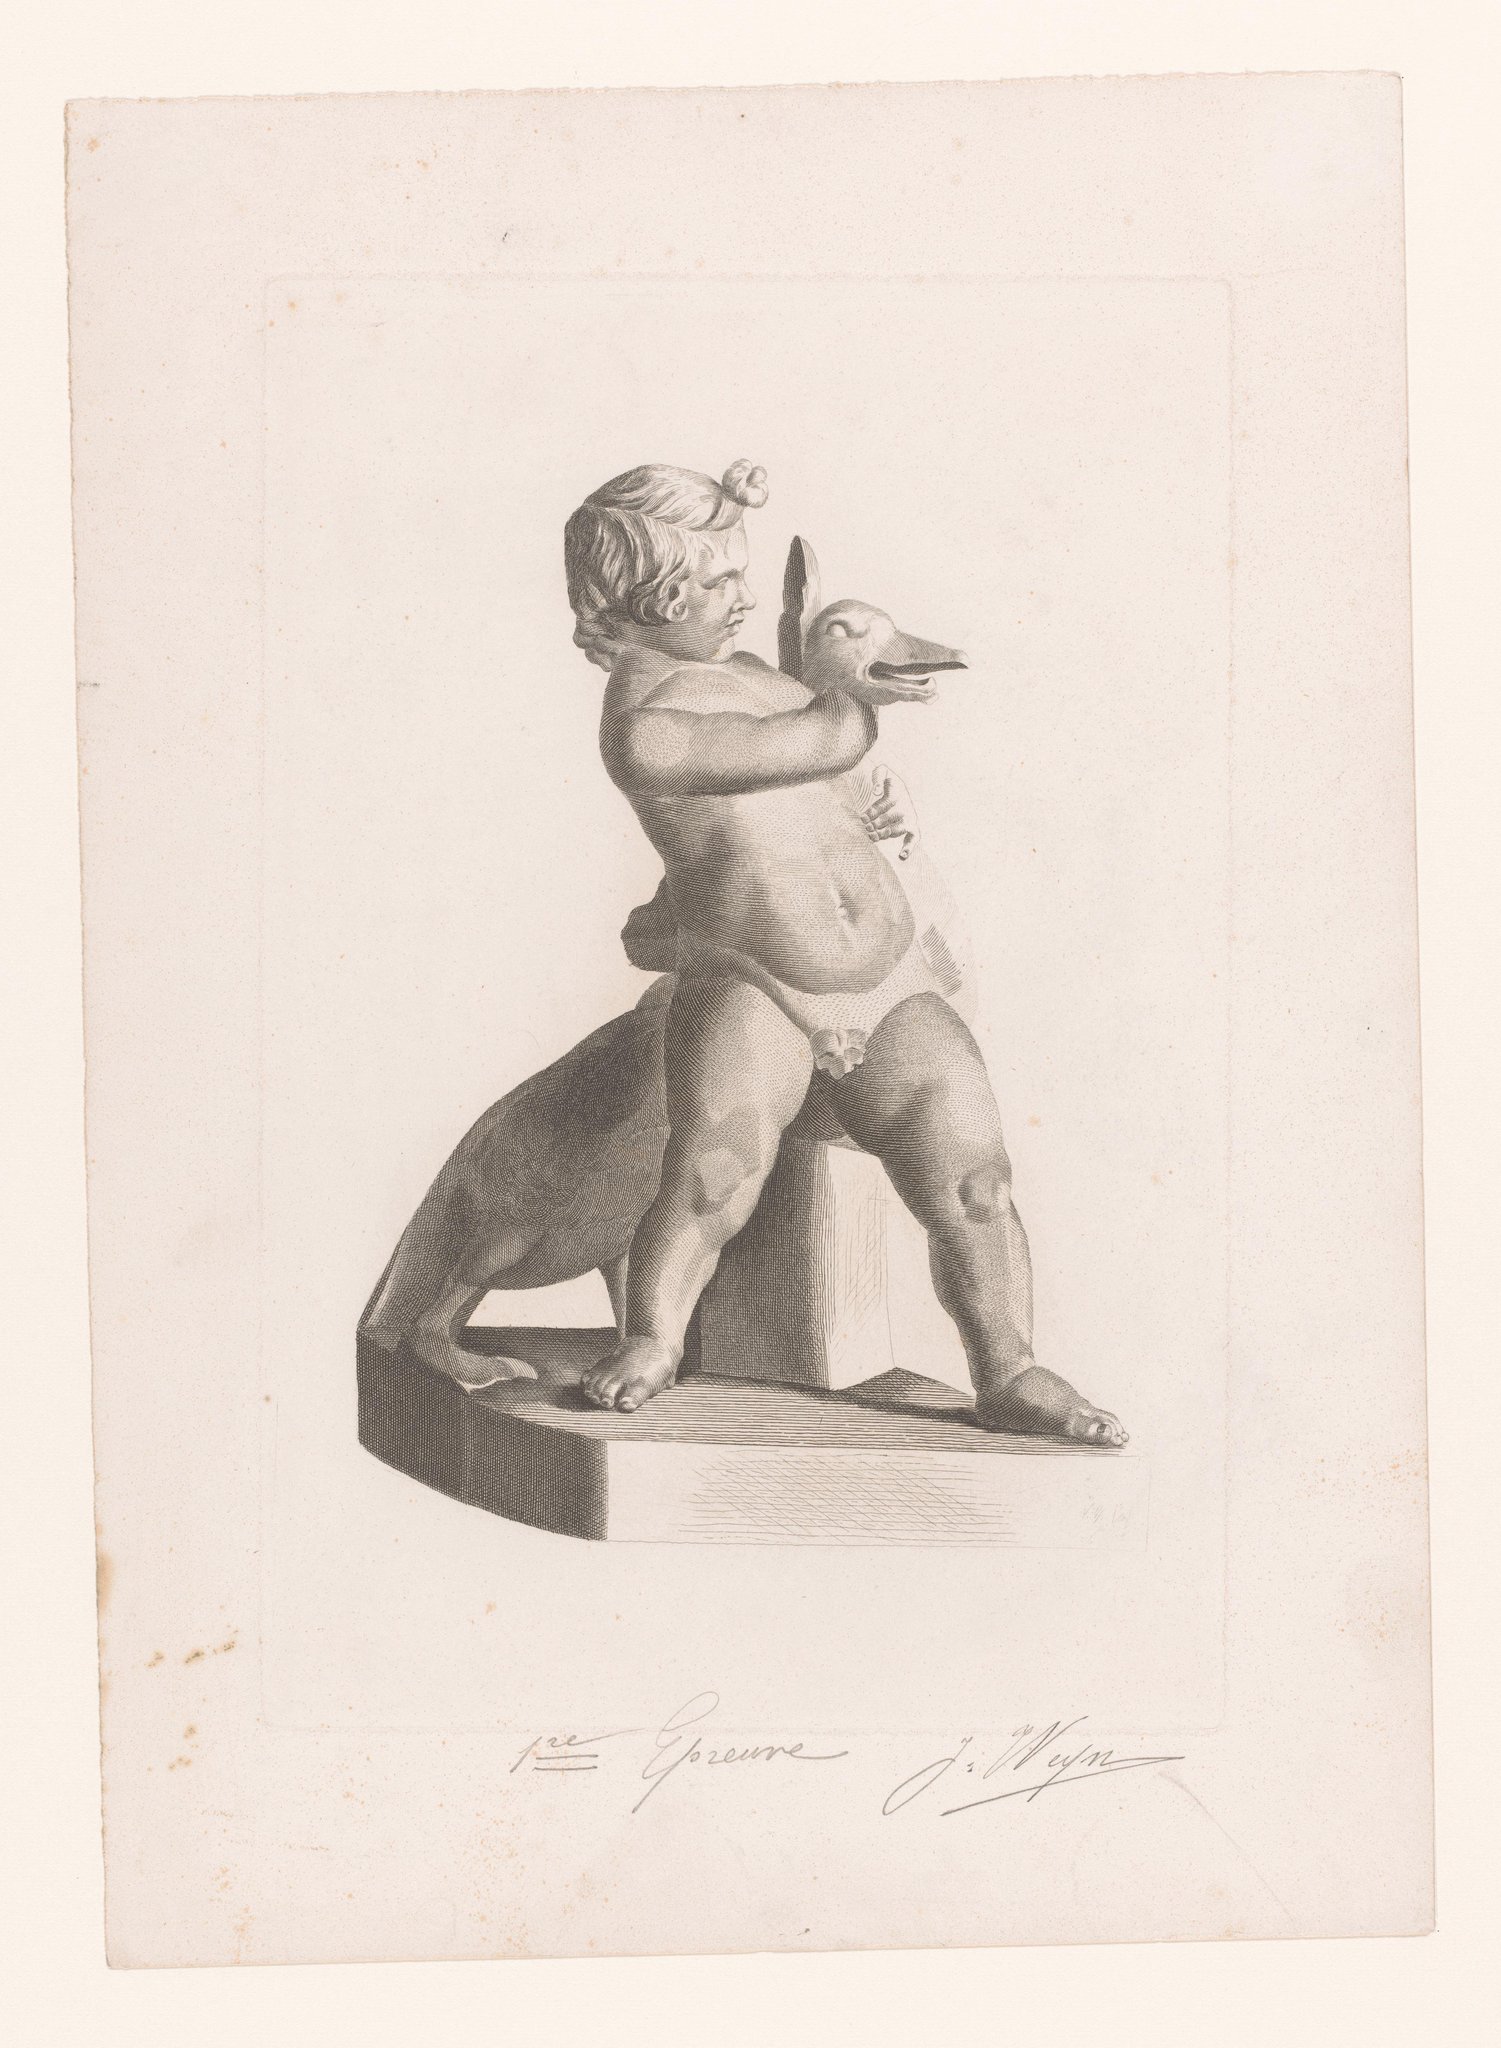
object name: print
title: Gans omarmd door een kind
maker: j. weyn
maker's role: print maker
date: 1888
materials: paper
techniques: engraving, etching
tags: water-birds: goose, child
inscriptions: collector's mark: Lugt 2228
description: Sterfdatum van de prentmaker is onbekend. Daarom is voor de bepaling van de rechten van dit object gebruik gemaakt van de verwervingsdatum Rijksmuseum Amsterdam.